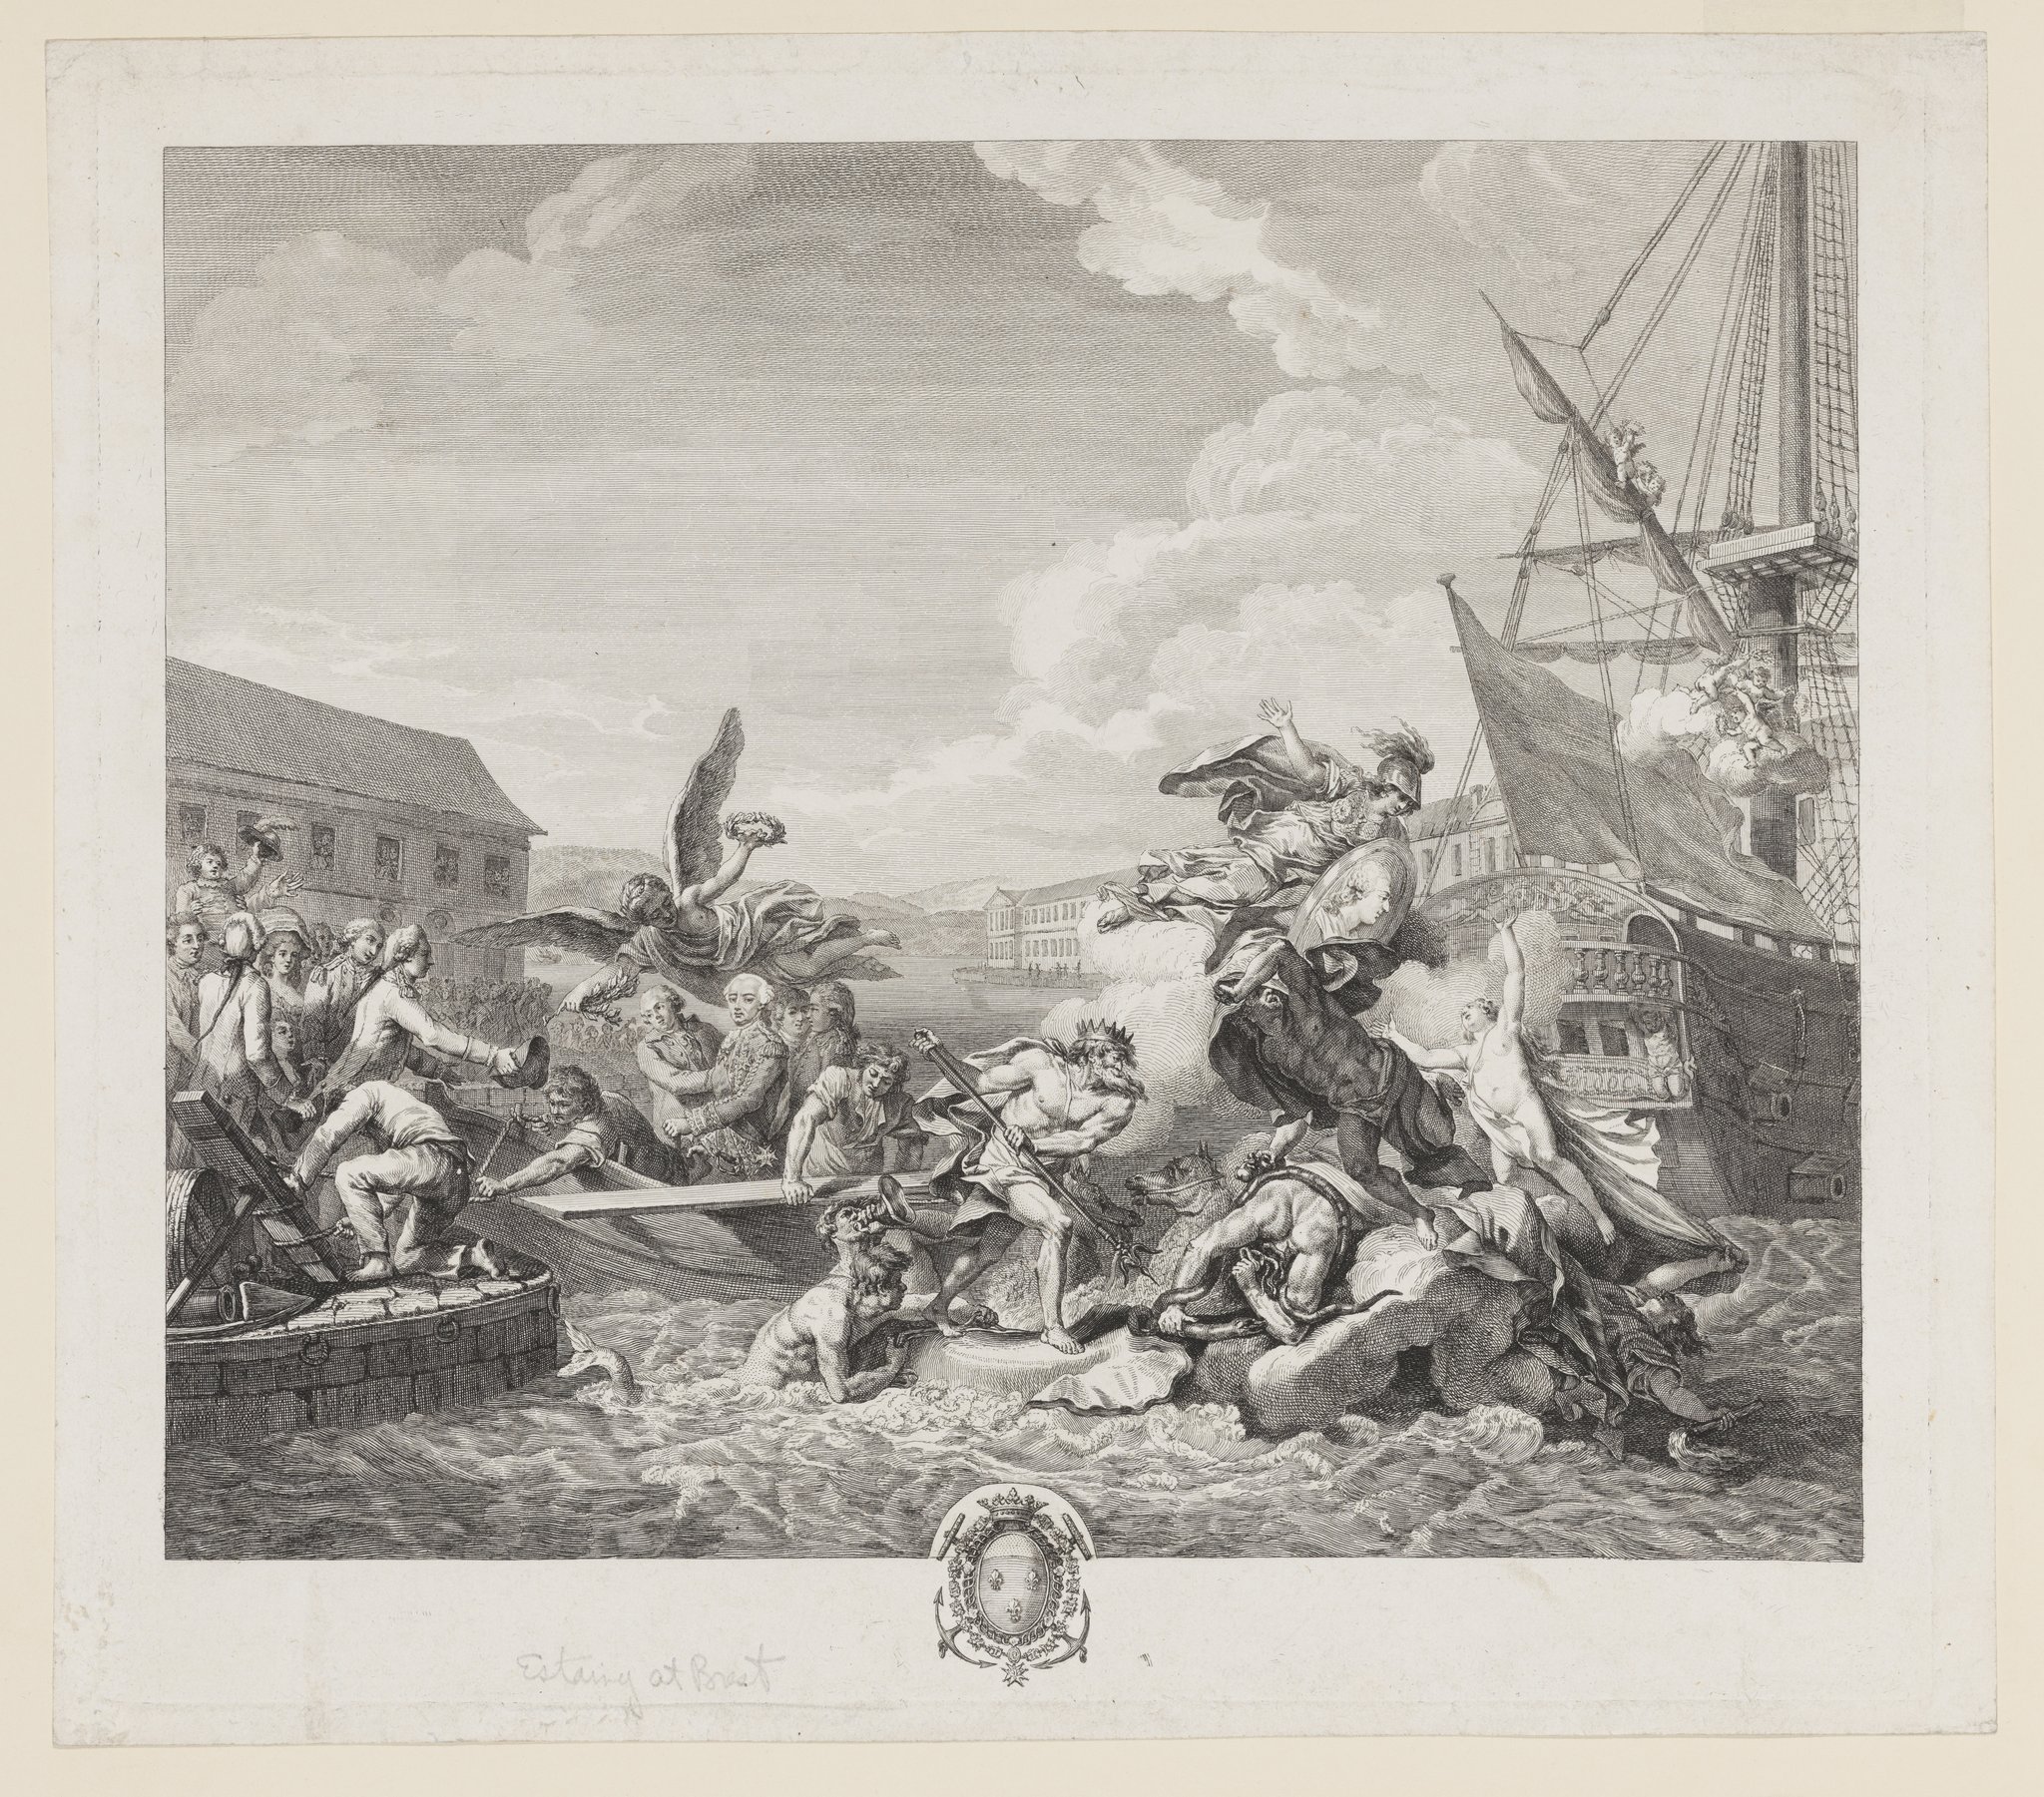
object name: print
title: The Arrival of Admiral d'Estaing at Brest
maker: pierre lacour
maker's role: etcher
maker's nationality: french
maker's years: 1745-1814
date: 1782-1790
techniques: engraving, etching